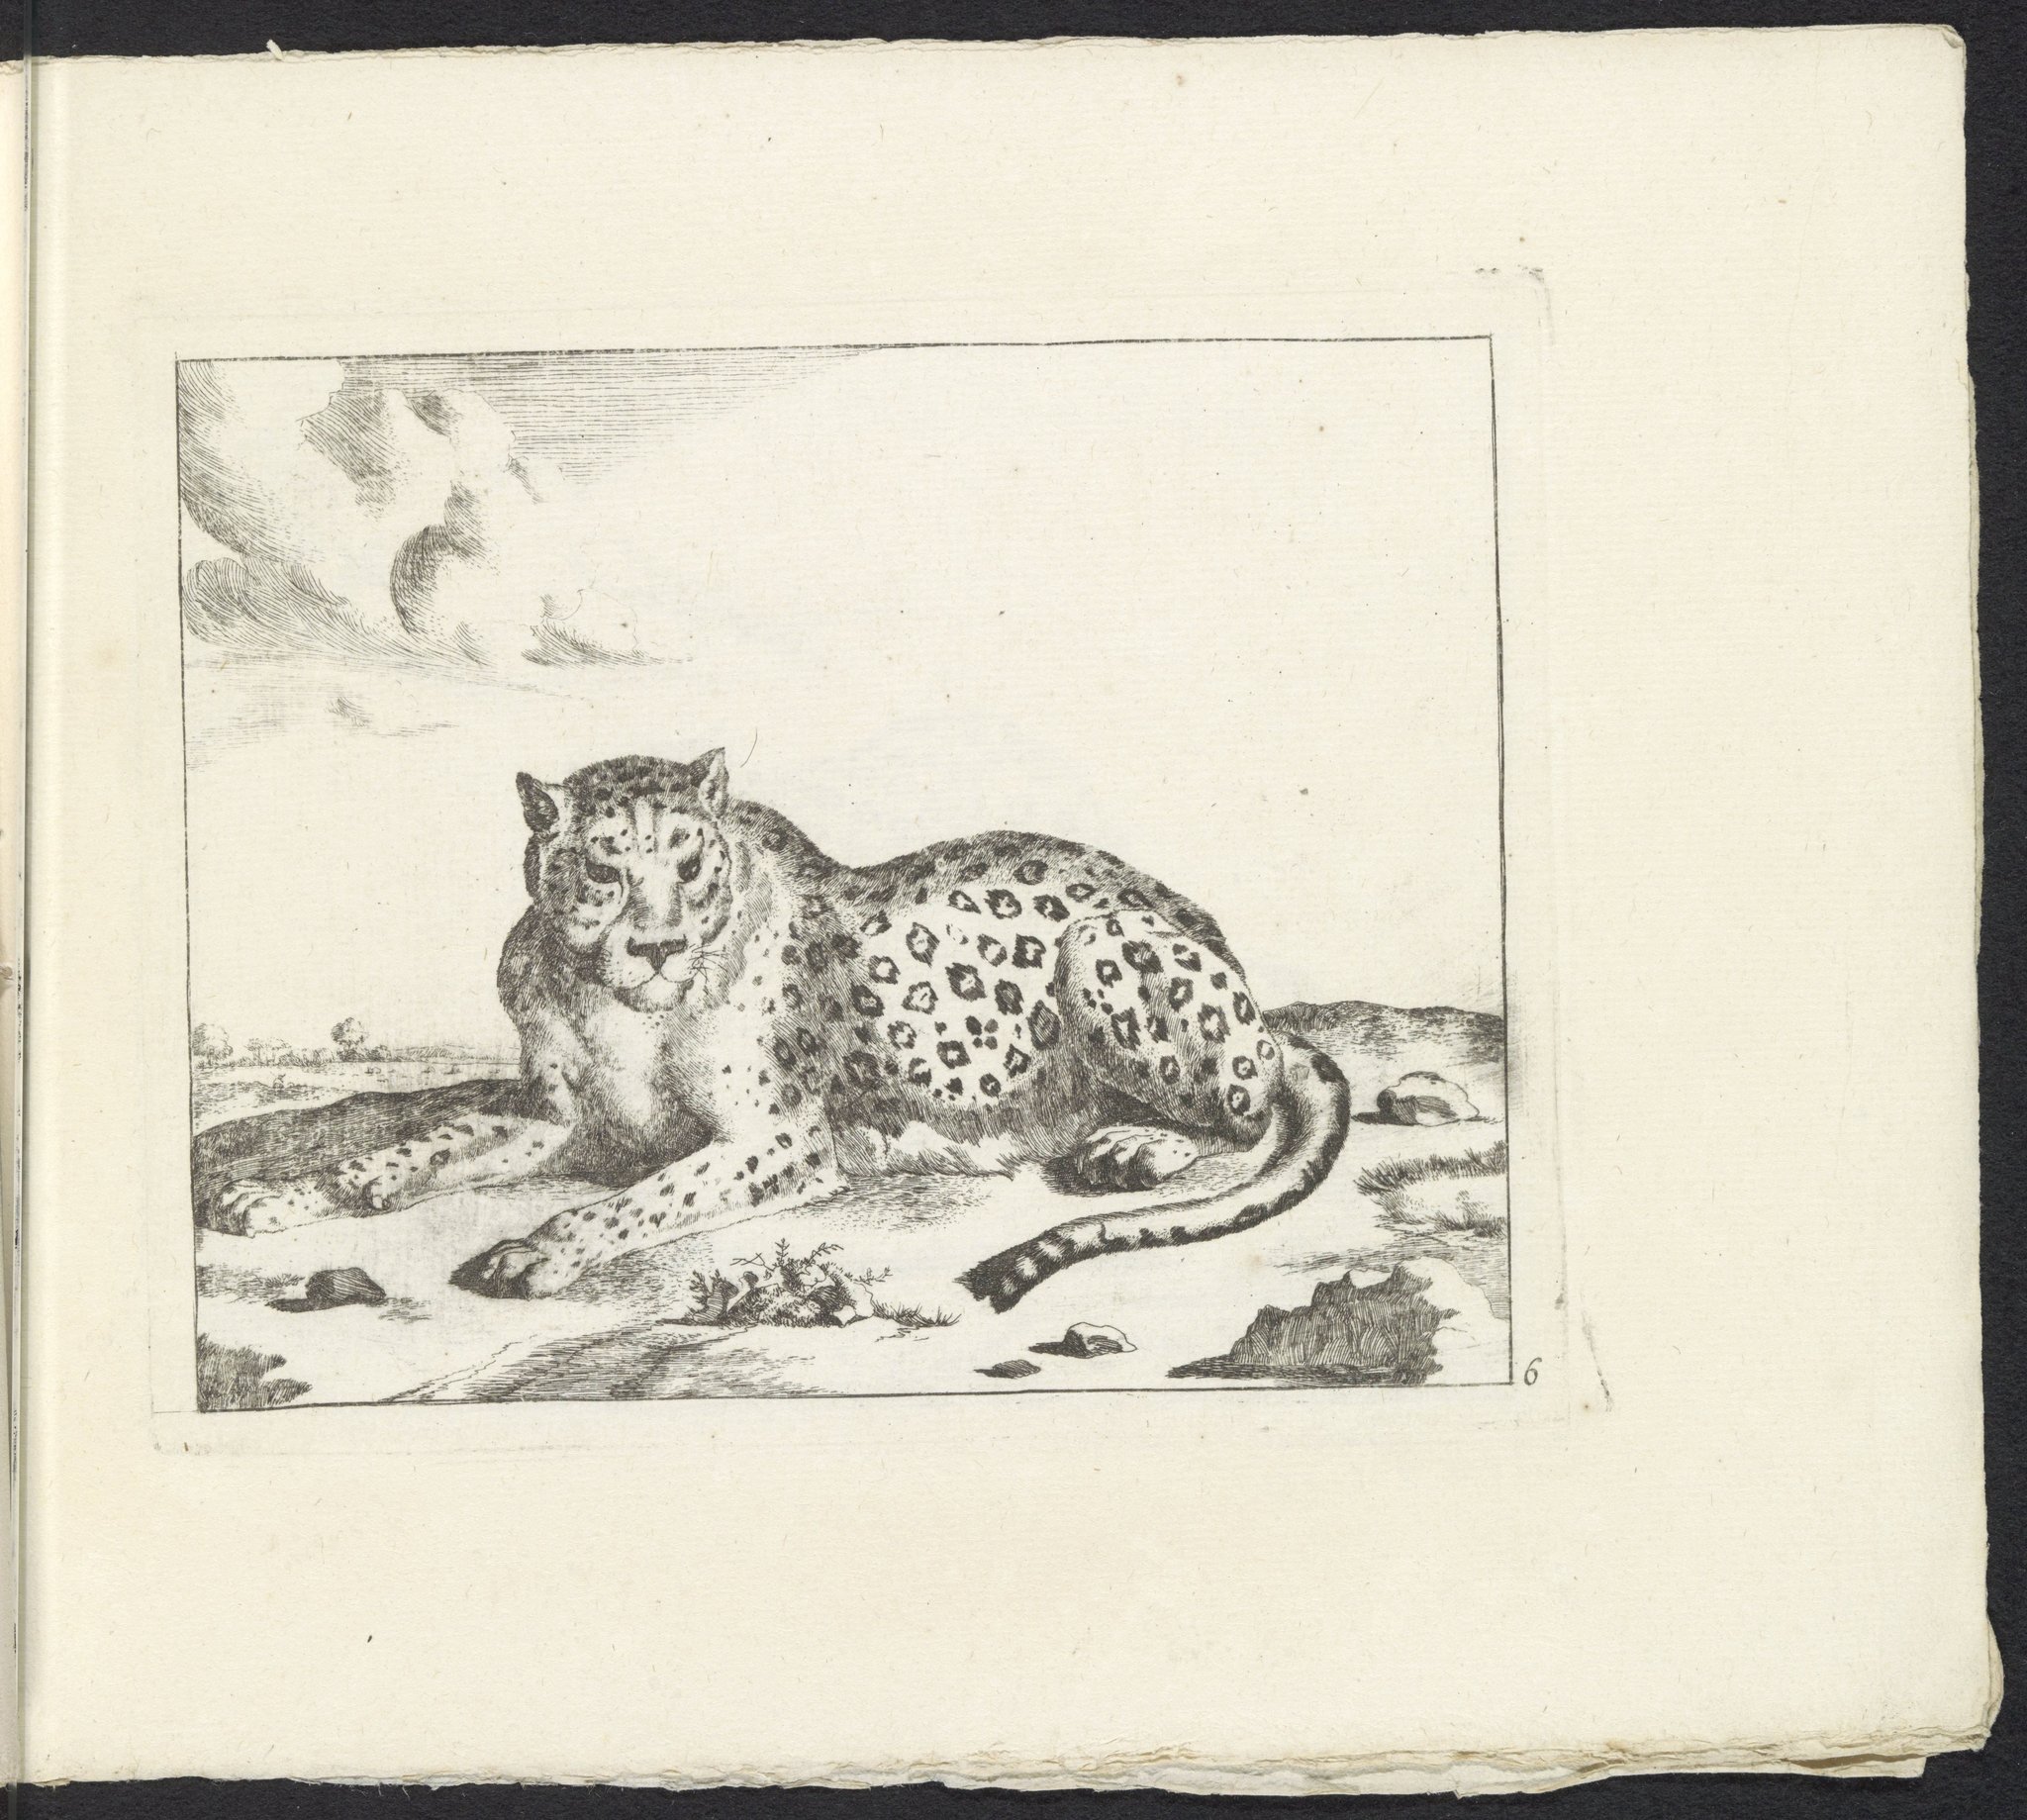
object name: print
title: Liggend luipaard, naar links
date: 1657-1677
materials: paper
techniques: etching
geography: northern netherlands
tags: beasts of prey, predatory animals: leopard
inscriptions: collector's mark: Lugt 2228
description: Liggend luipaard, naar links. Prent uit een serie van acht genummerde prenten met ''naar het leven'' getekende luipaarden, de reeks aan bindtouw.